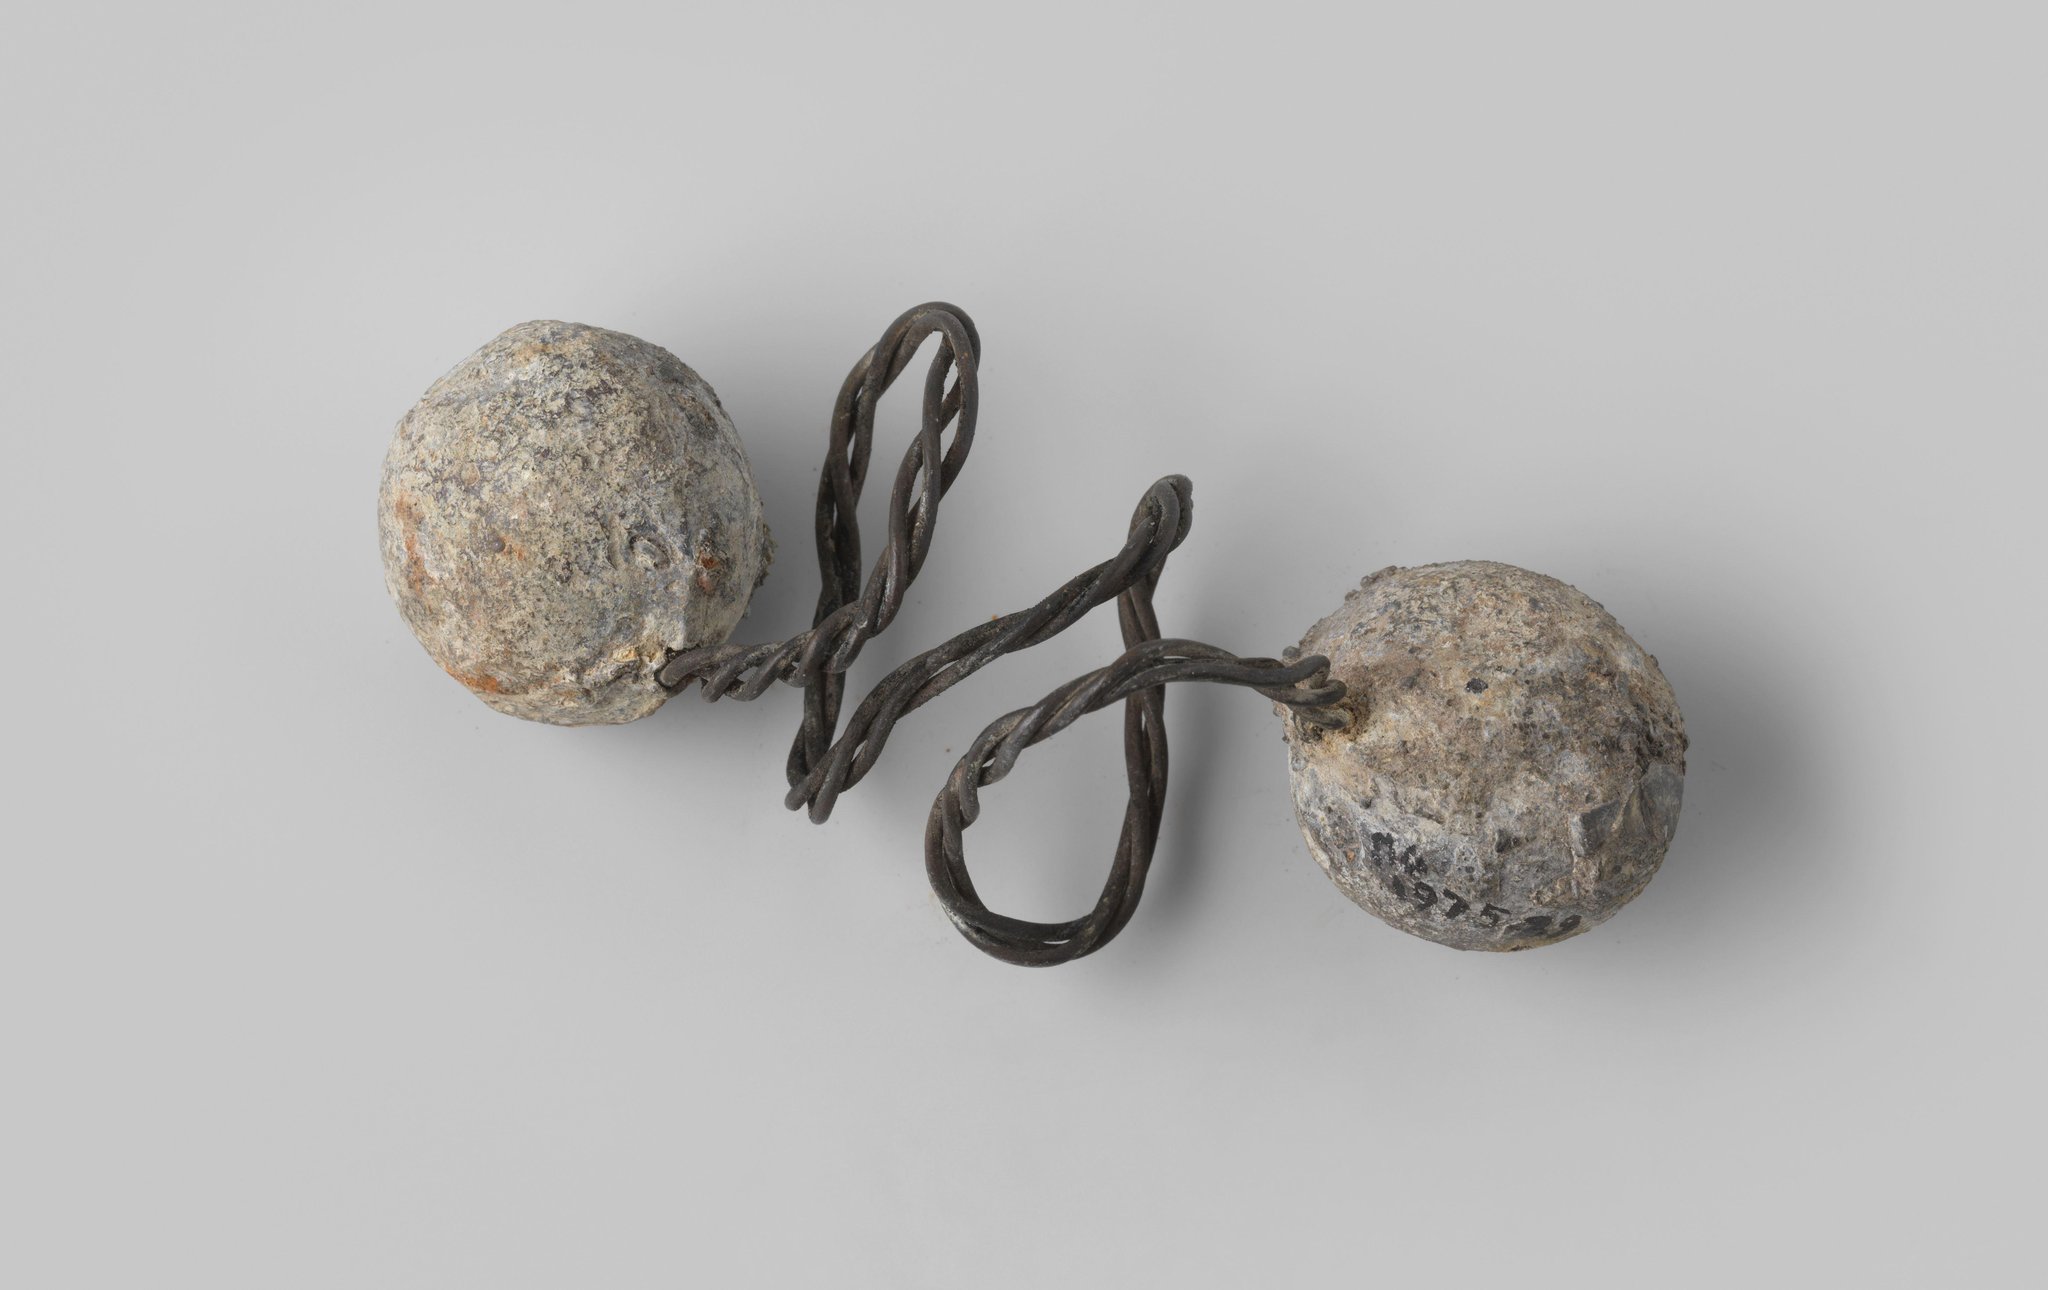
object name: chain shot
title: Kettingkogel uit het wrak van de Oost-Indiëvaarder Hollandia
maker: Anonymous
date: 1700-1743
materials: lead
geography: netherlands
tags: verenigde oostindische compagnie, hollandia (schip), annet